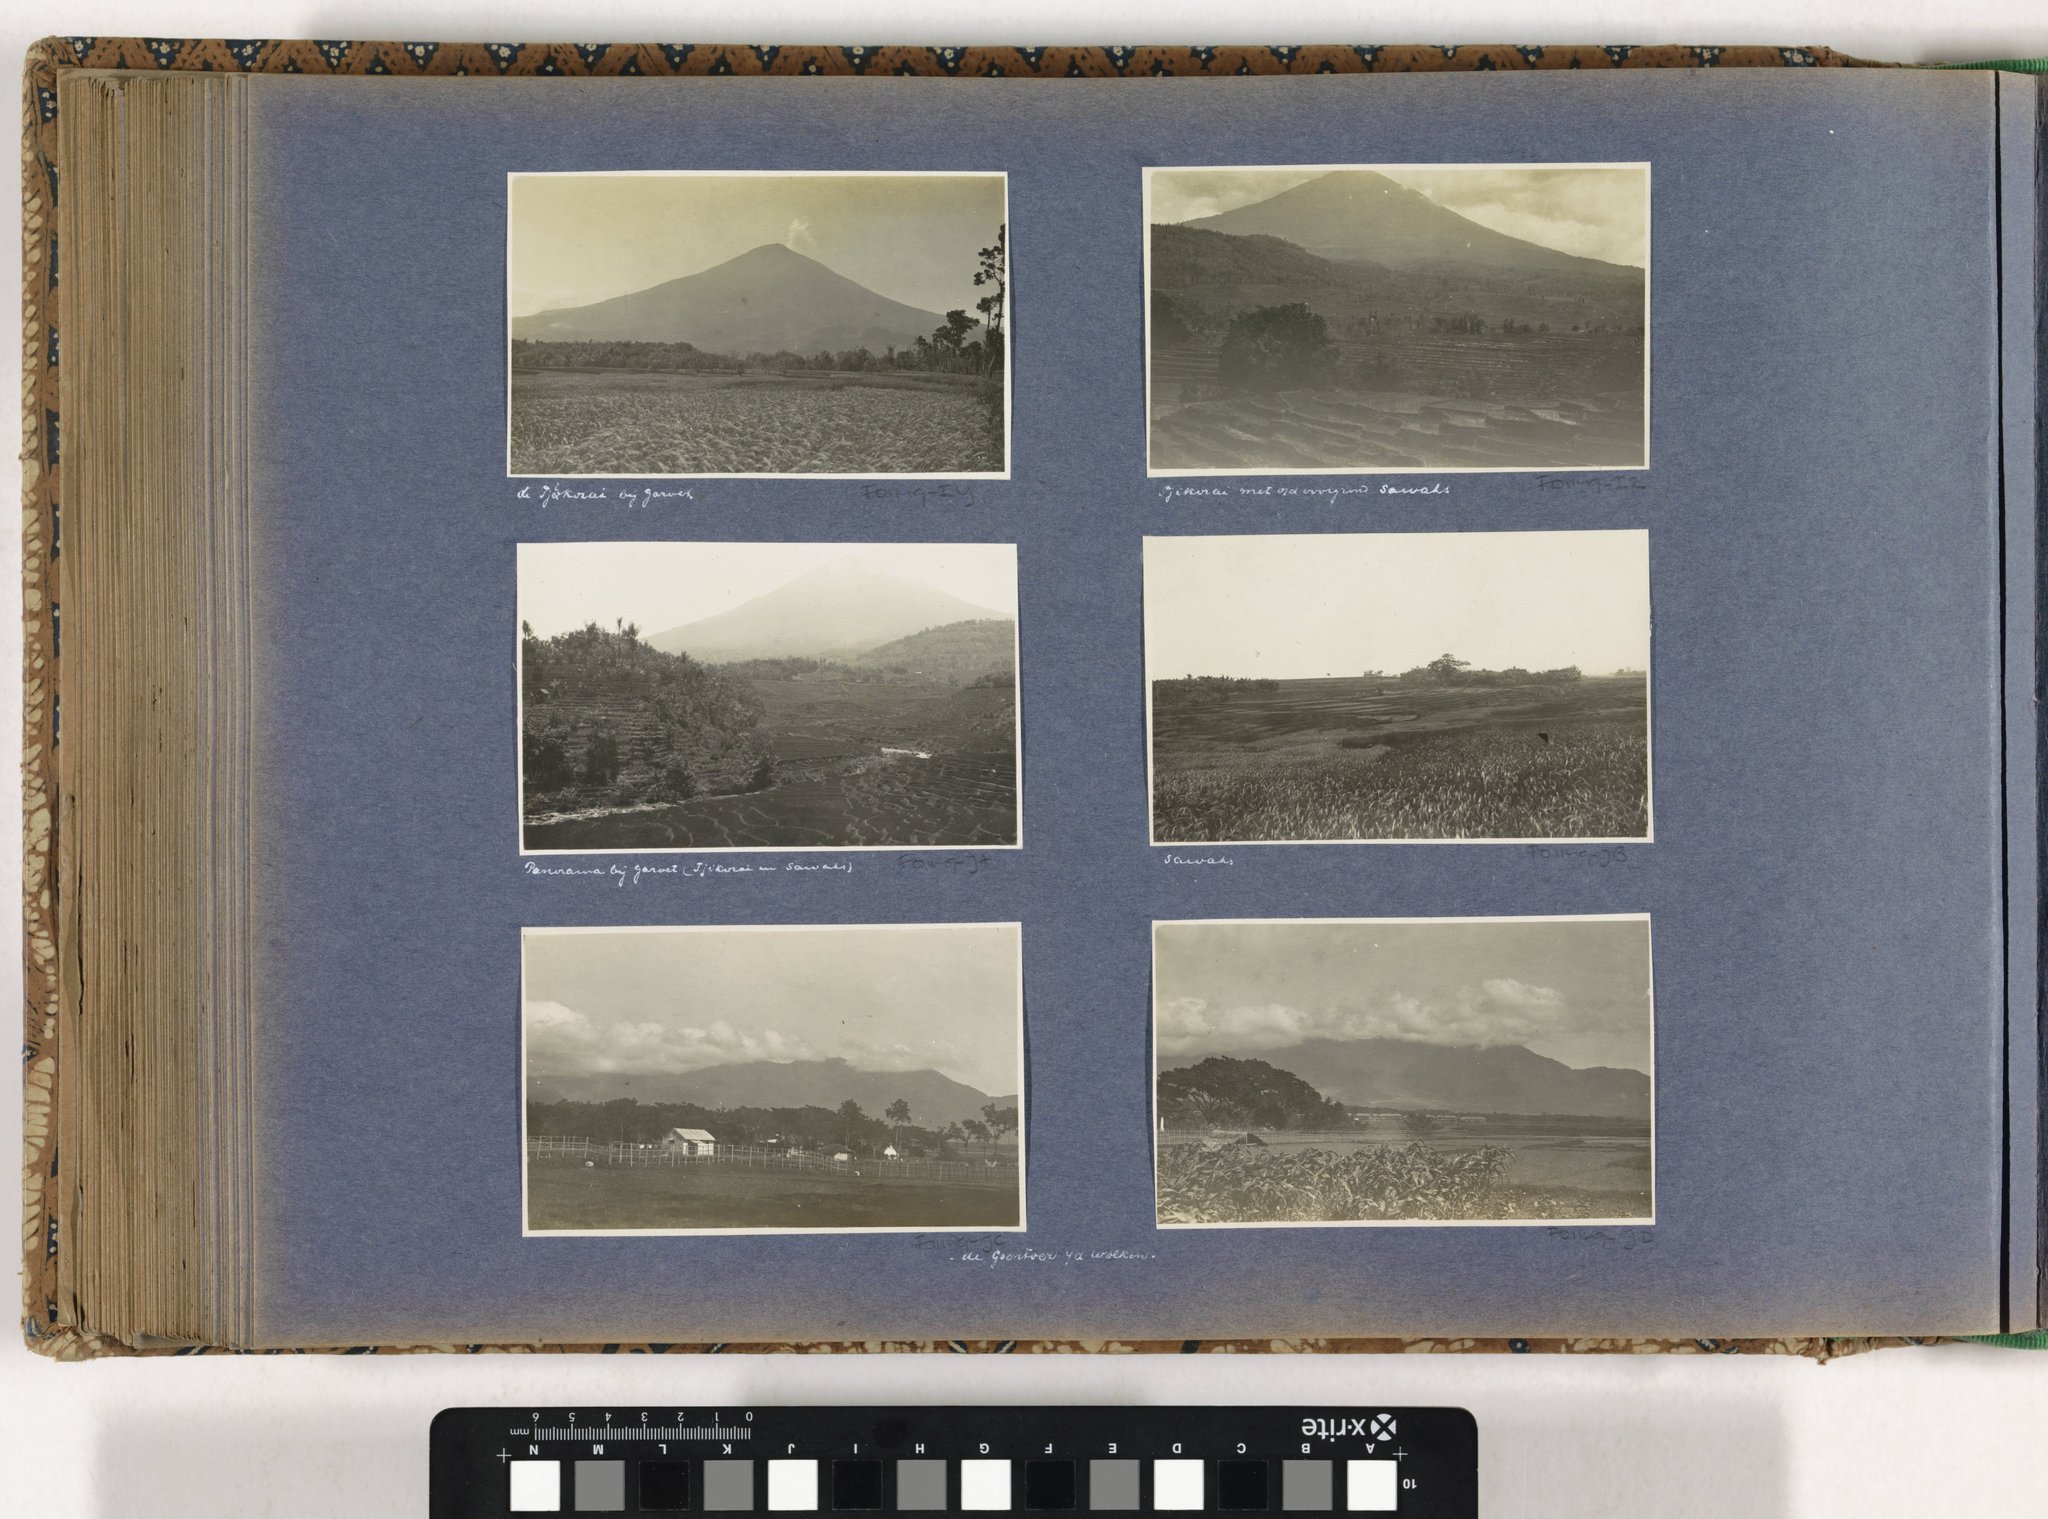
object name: photograph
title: Vulkaan Tjikorai bij Garut gezien over velden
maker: Anonymous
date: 1900-1920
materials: paper, photographic support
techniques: gelatin silver print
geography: garut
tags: volcano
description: Onderdeel van reisalbum met foto's van bedrijvigheid en bezienswaardigheden op Sumatra en Java en van de reis naar en van Nederlands-Indië.